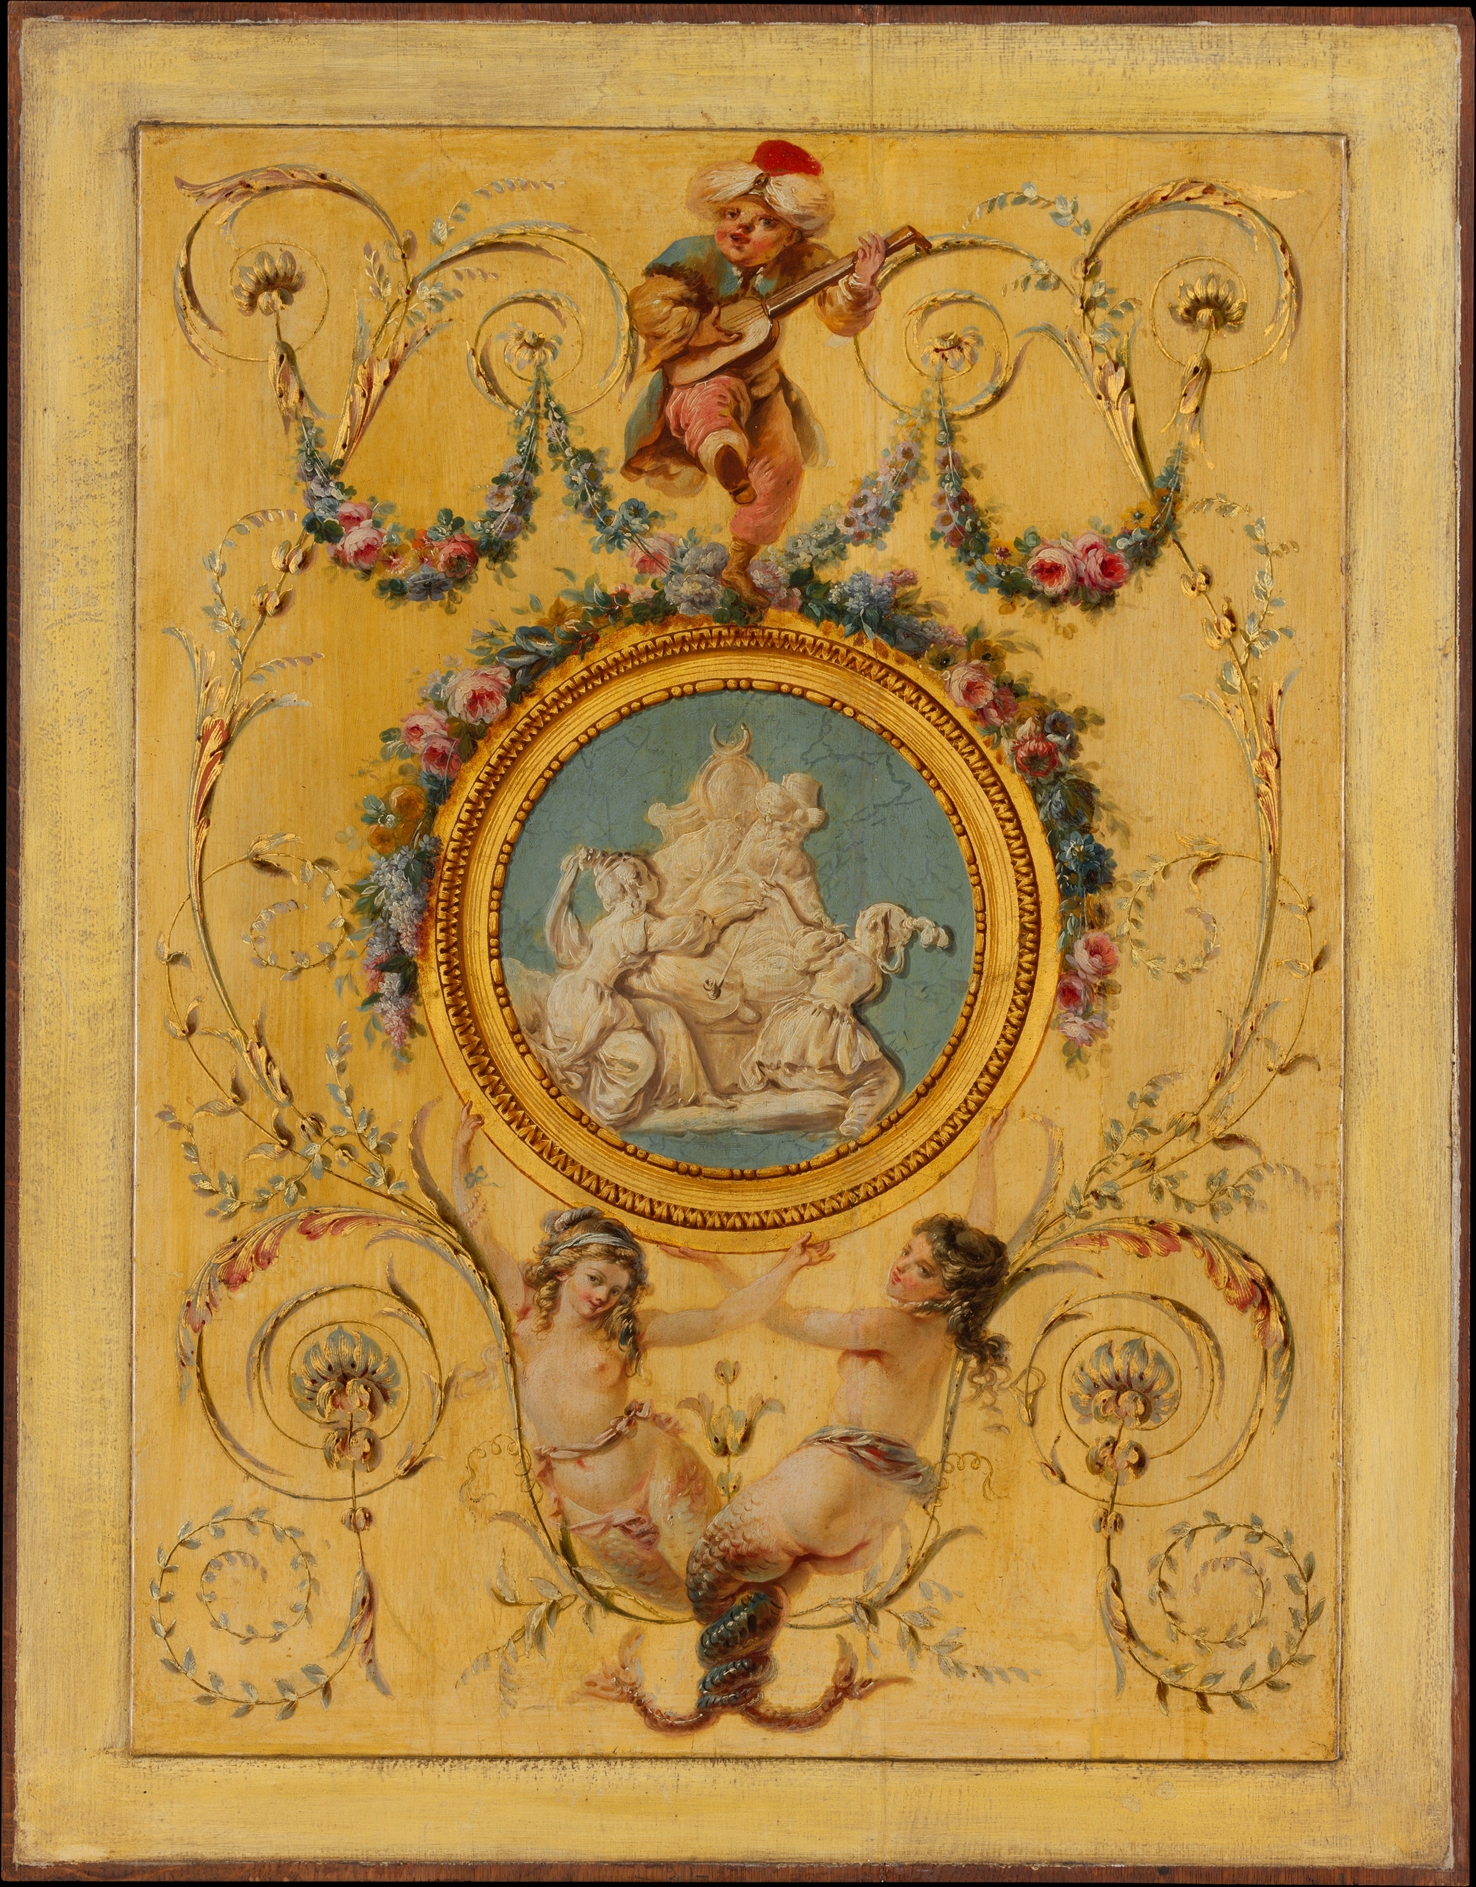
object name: panel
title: Door panel from the "Cabinet Turc" of Comte d'Artois at Versailles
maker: jean -siméon rousseau de la rottière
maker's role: artist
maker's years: 1747-1820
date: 1781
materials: wood, oil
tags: garlands,boys,men,women